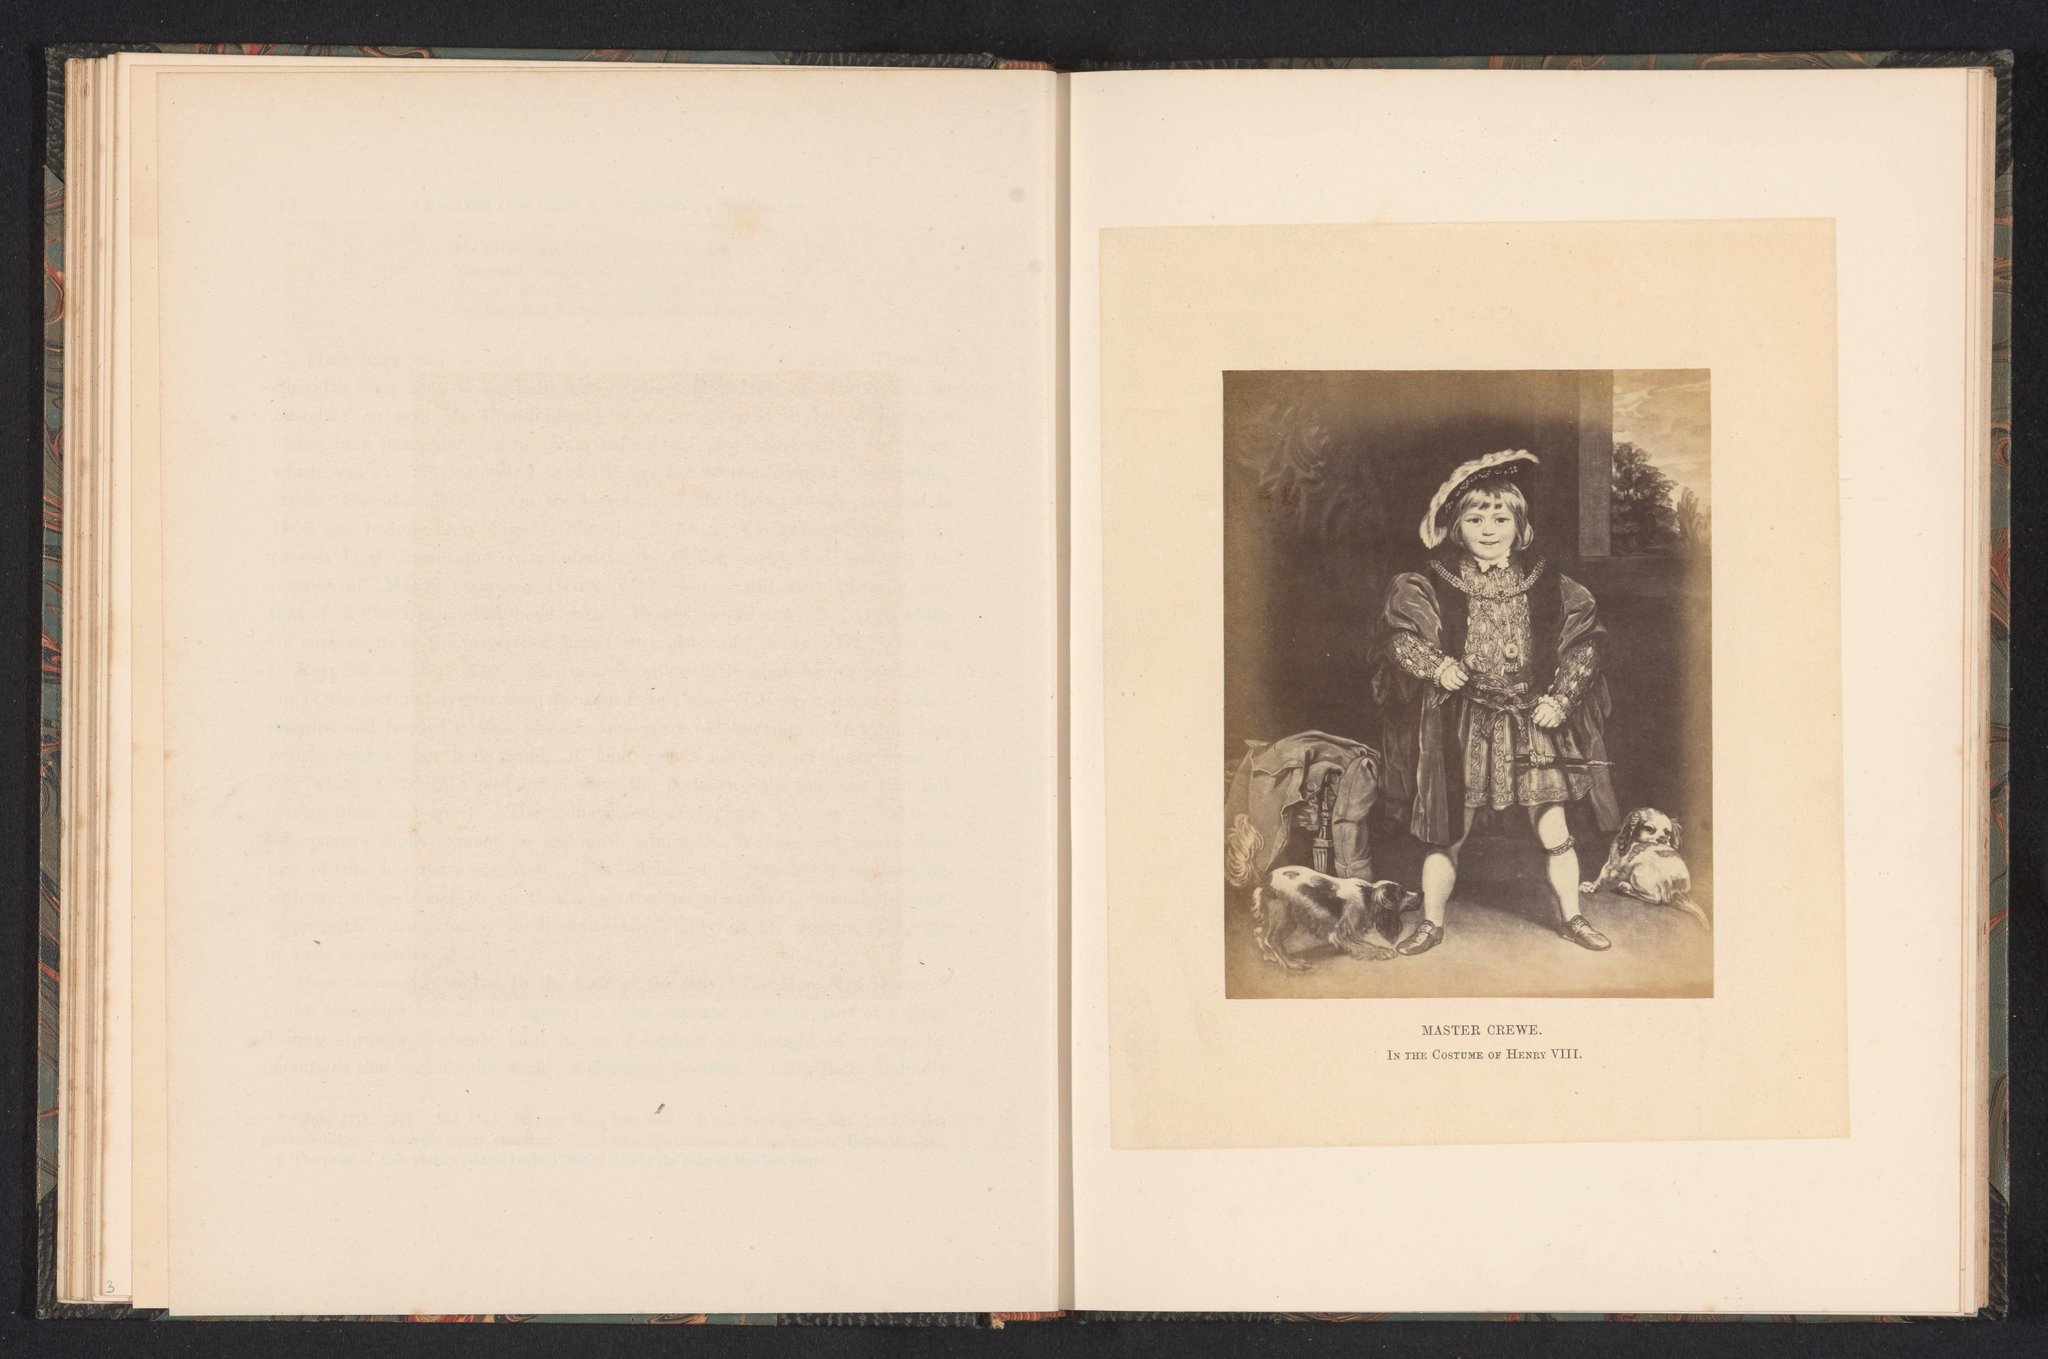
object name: page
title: Fotoreproductie van een portret van John Crewe als kind door Joshua Reynolds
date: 1857-1867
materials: photographic support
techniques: albumen print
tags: boy (child between toddler and youth), picture, painting